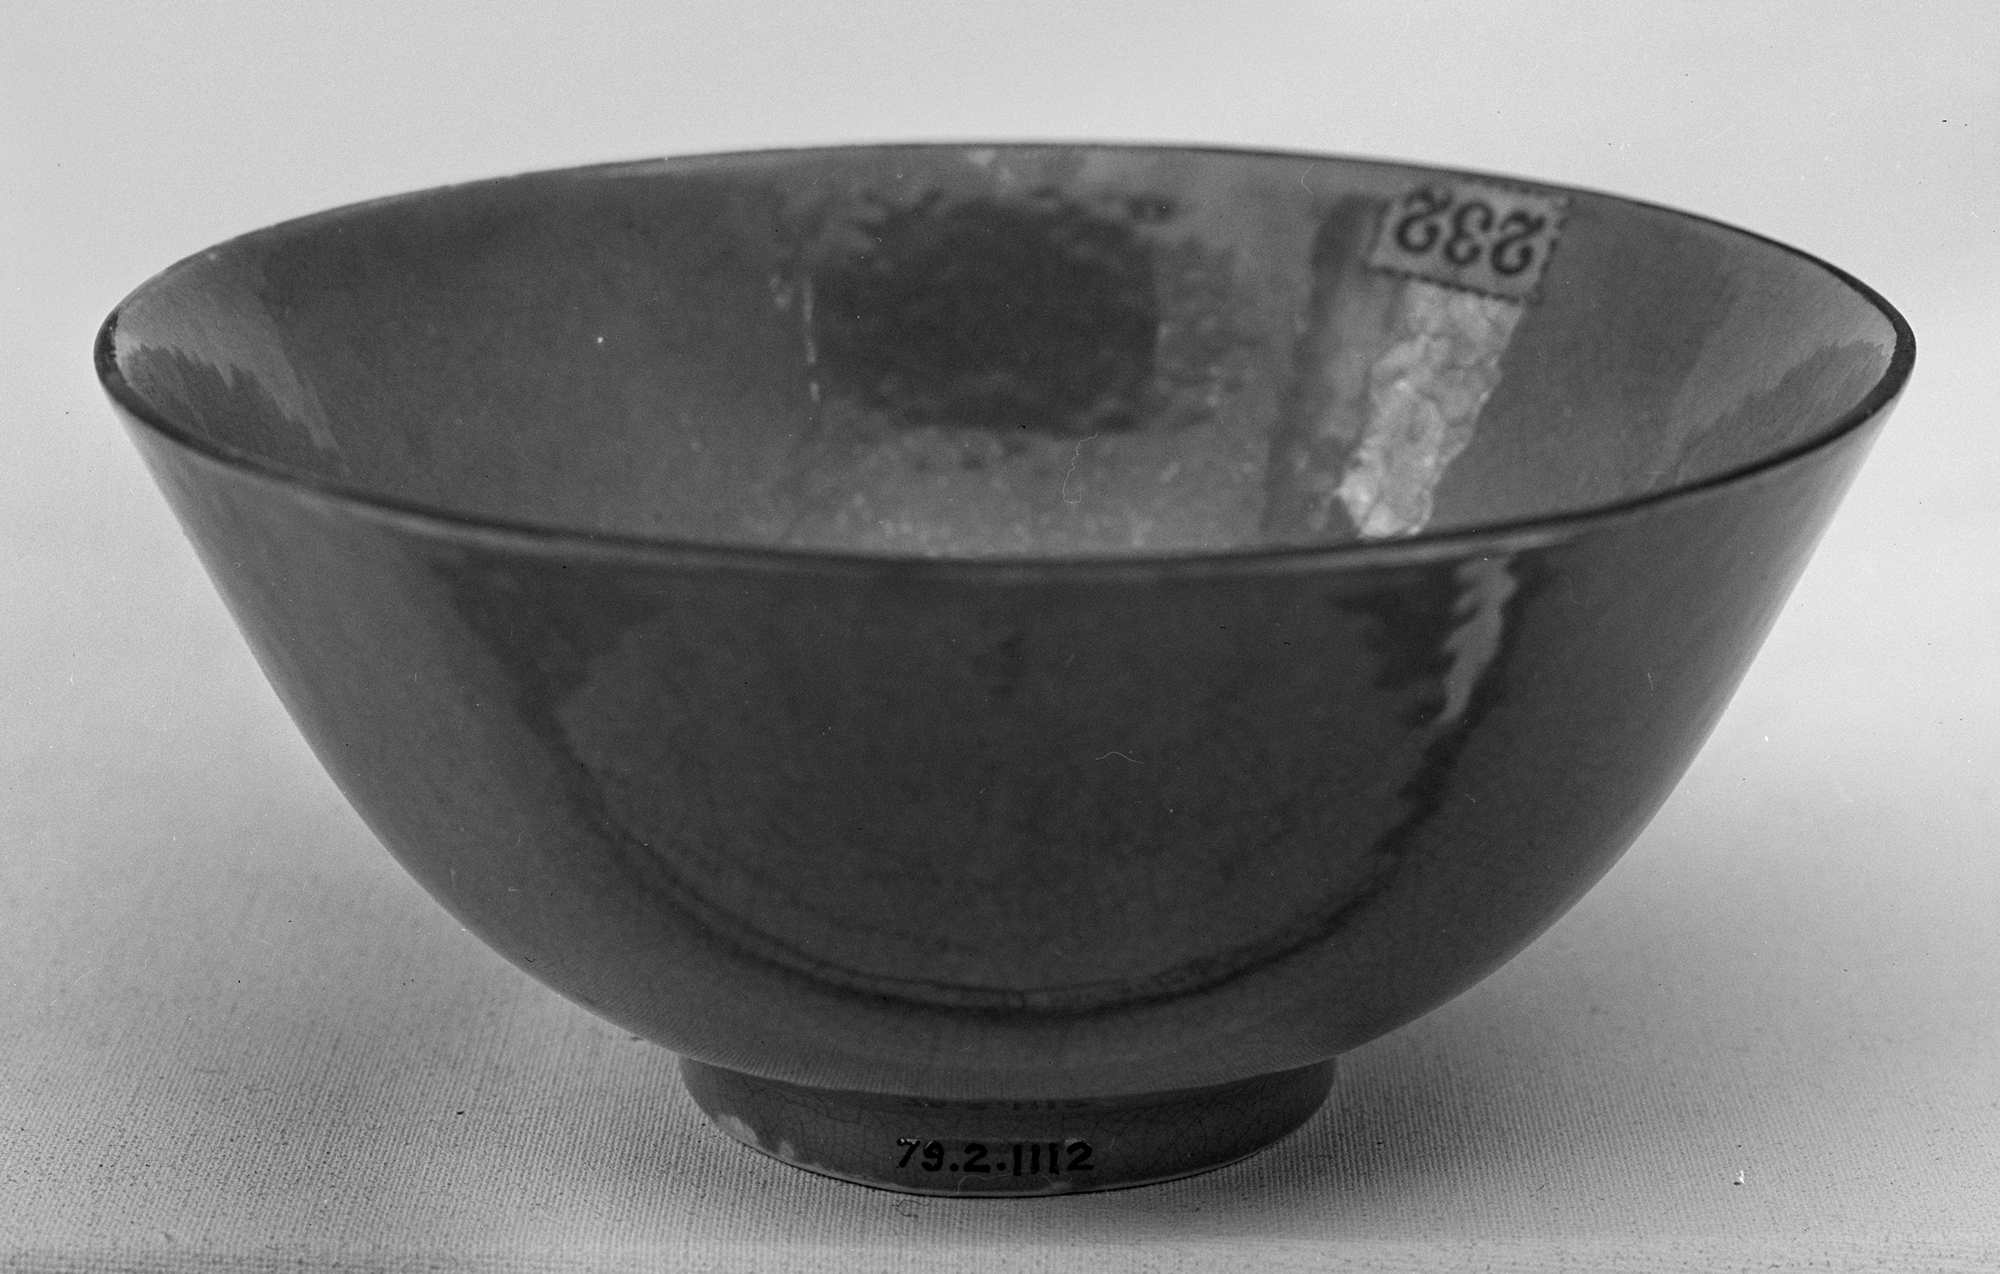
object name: bowl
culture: chinese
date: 1801-1850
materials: glaze, porcelain